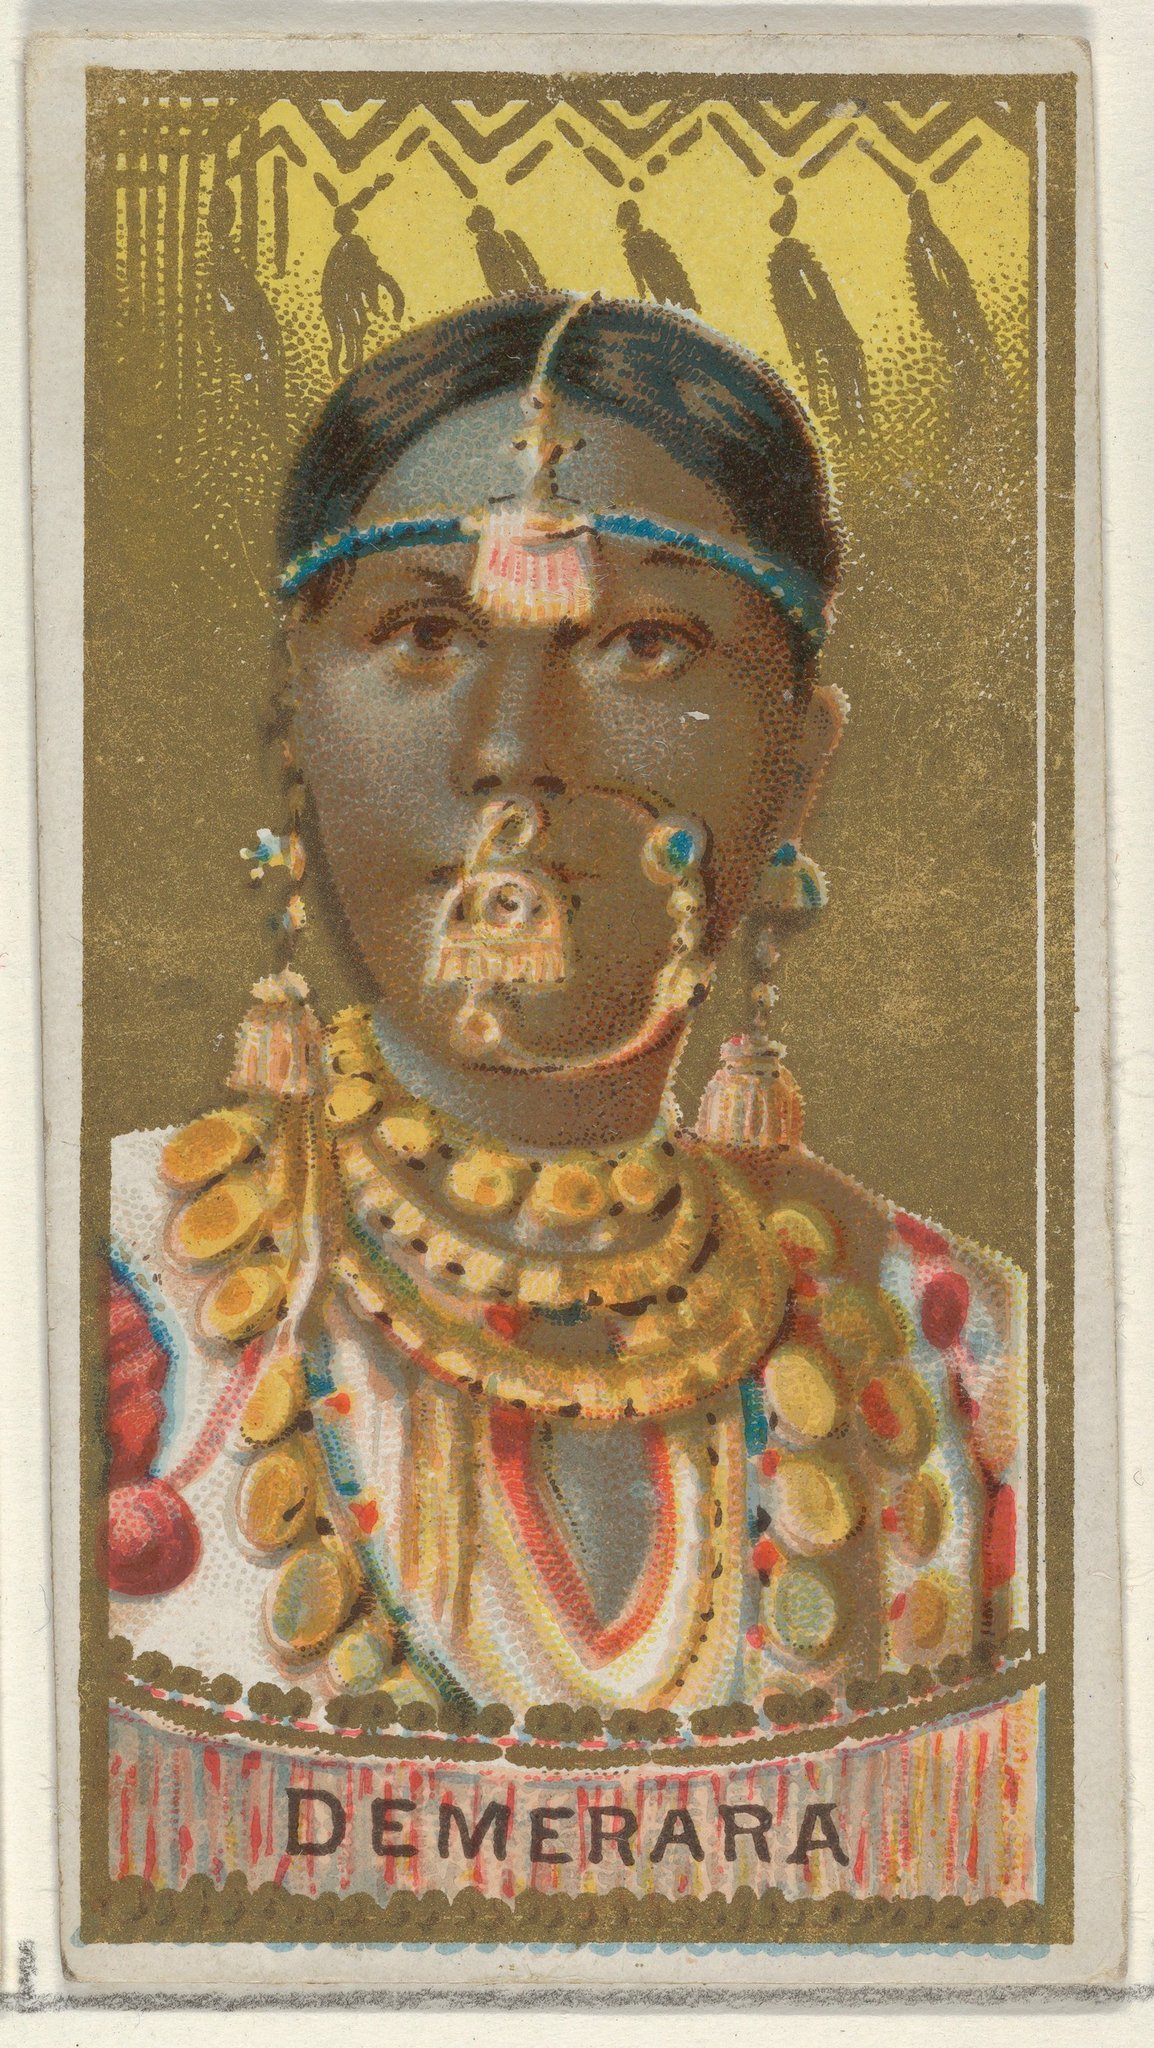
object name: print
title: Demerara, from the Types of All Nations series (N24) for Allen & Ginter Cigarettes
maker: allen & ginter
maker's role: publisher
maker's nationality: american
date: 1889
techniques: color lithograph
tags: women